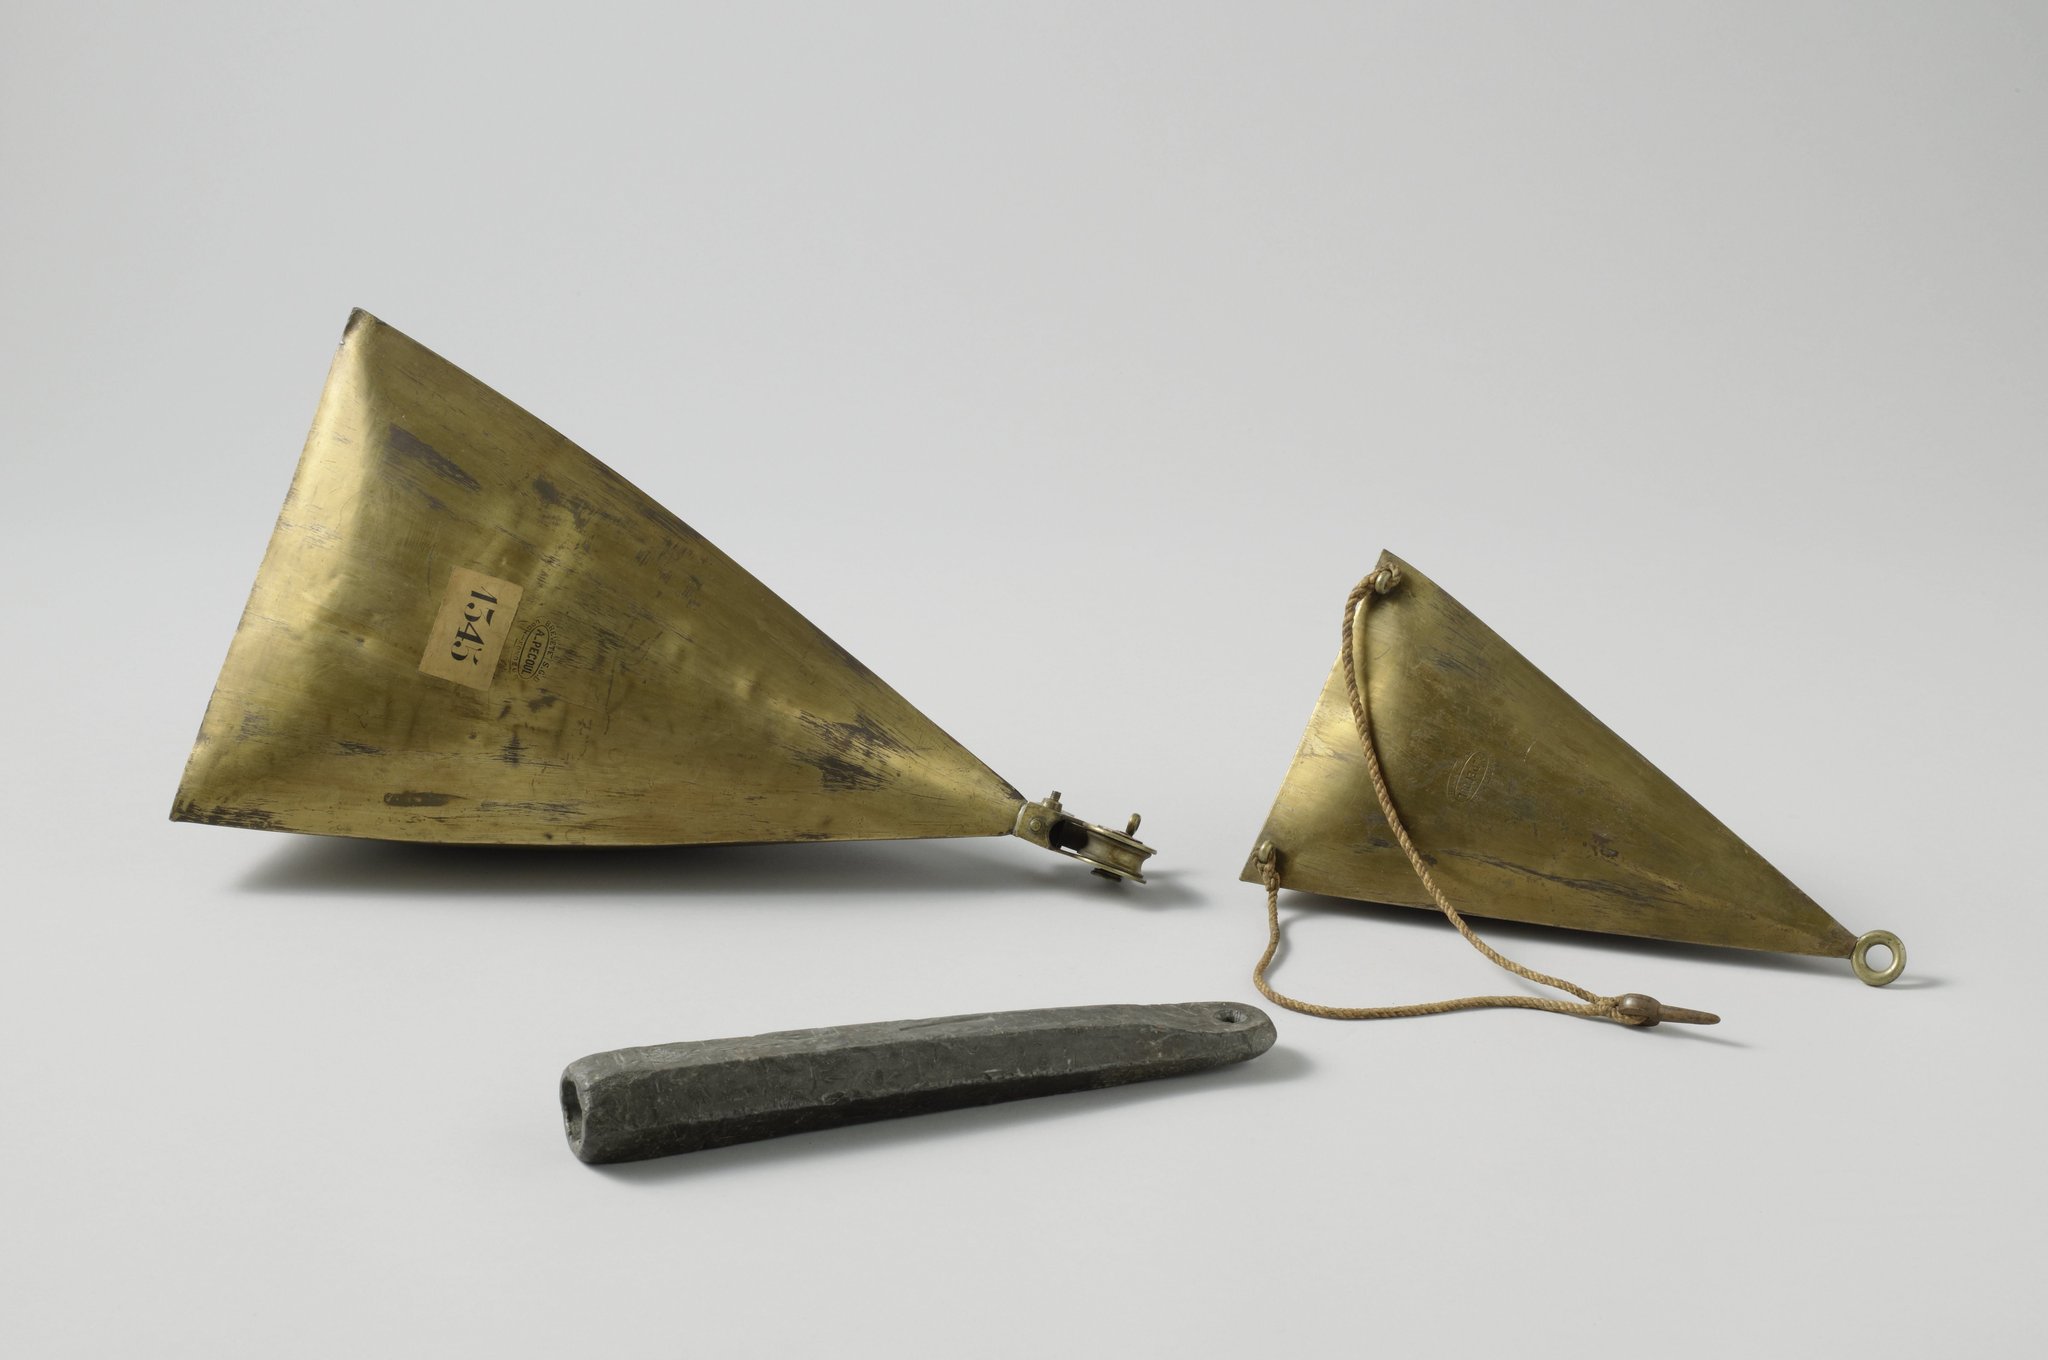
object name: buoy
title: Log, Sounding Lead and Brochure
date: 1855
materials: brass, lead, paper, fiber, wood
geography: marseille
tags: paris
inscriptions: inscription, on the cover of the brochure: ‘NOTICE ET DESCRIPTION / DU / LOCH-SONDEUR / [...] PAR / M. ADOLPHE PÉCOUL [...] / MARSEILLE [...] / 1855.’, inscription, on both buoys: ‘BREVETE S.G.D.G. / A. PECOUL / LOCH-SONDEUR’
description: Pécoul's uitvinding, zoals beschreven in de brochure, werkte met slechts één boei, die zowel als log en als dieplood werd gebruikt. Indien als log gebruikt, werd de boei met het lood op een vastgestelde afstand verzwaard en de pal in het houten cilindertje op het viertouw gestoken, zodat de boei met zijn punt naar beneden in het water komt te liggen en een vlakke kant aan de vaarrichting biedt: zo gauw als het viertouw strak komt te staan, laat de pal los. Zoals bij een gewoon log wordt de snelheid van het schip afgeleid uit de lengte van het gevierde touw in een bepaalde tijd. Het gebruik van het lood maakte het minder gevoelig voor stromingen.